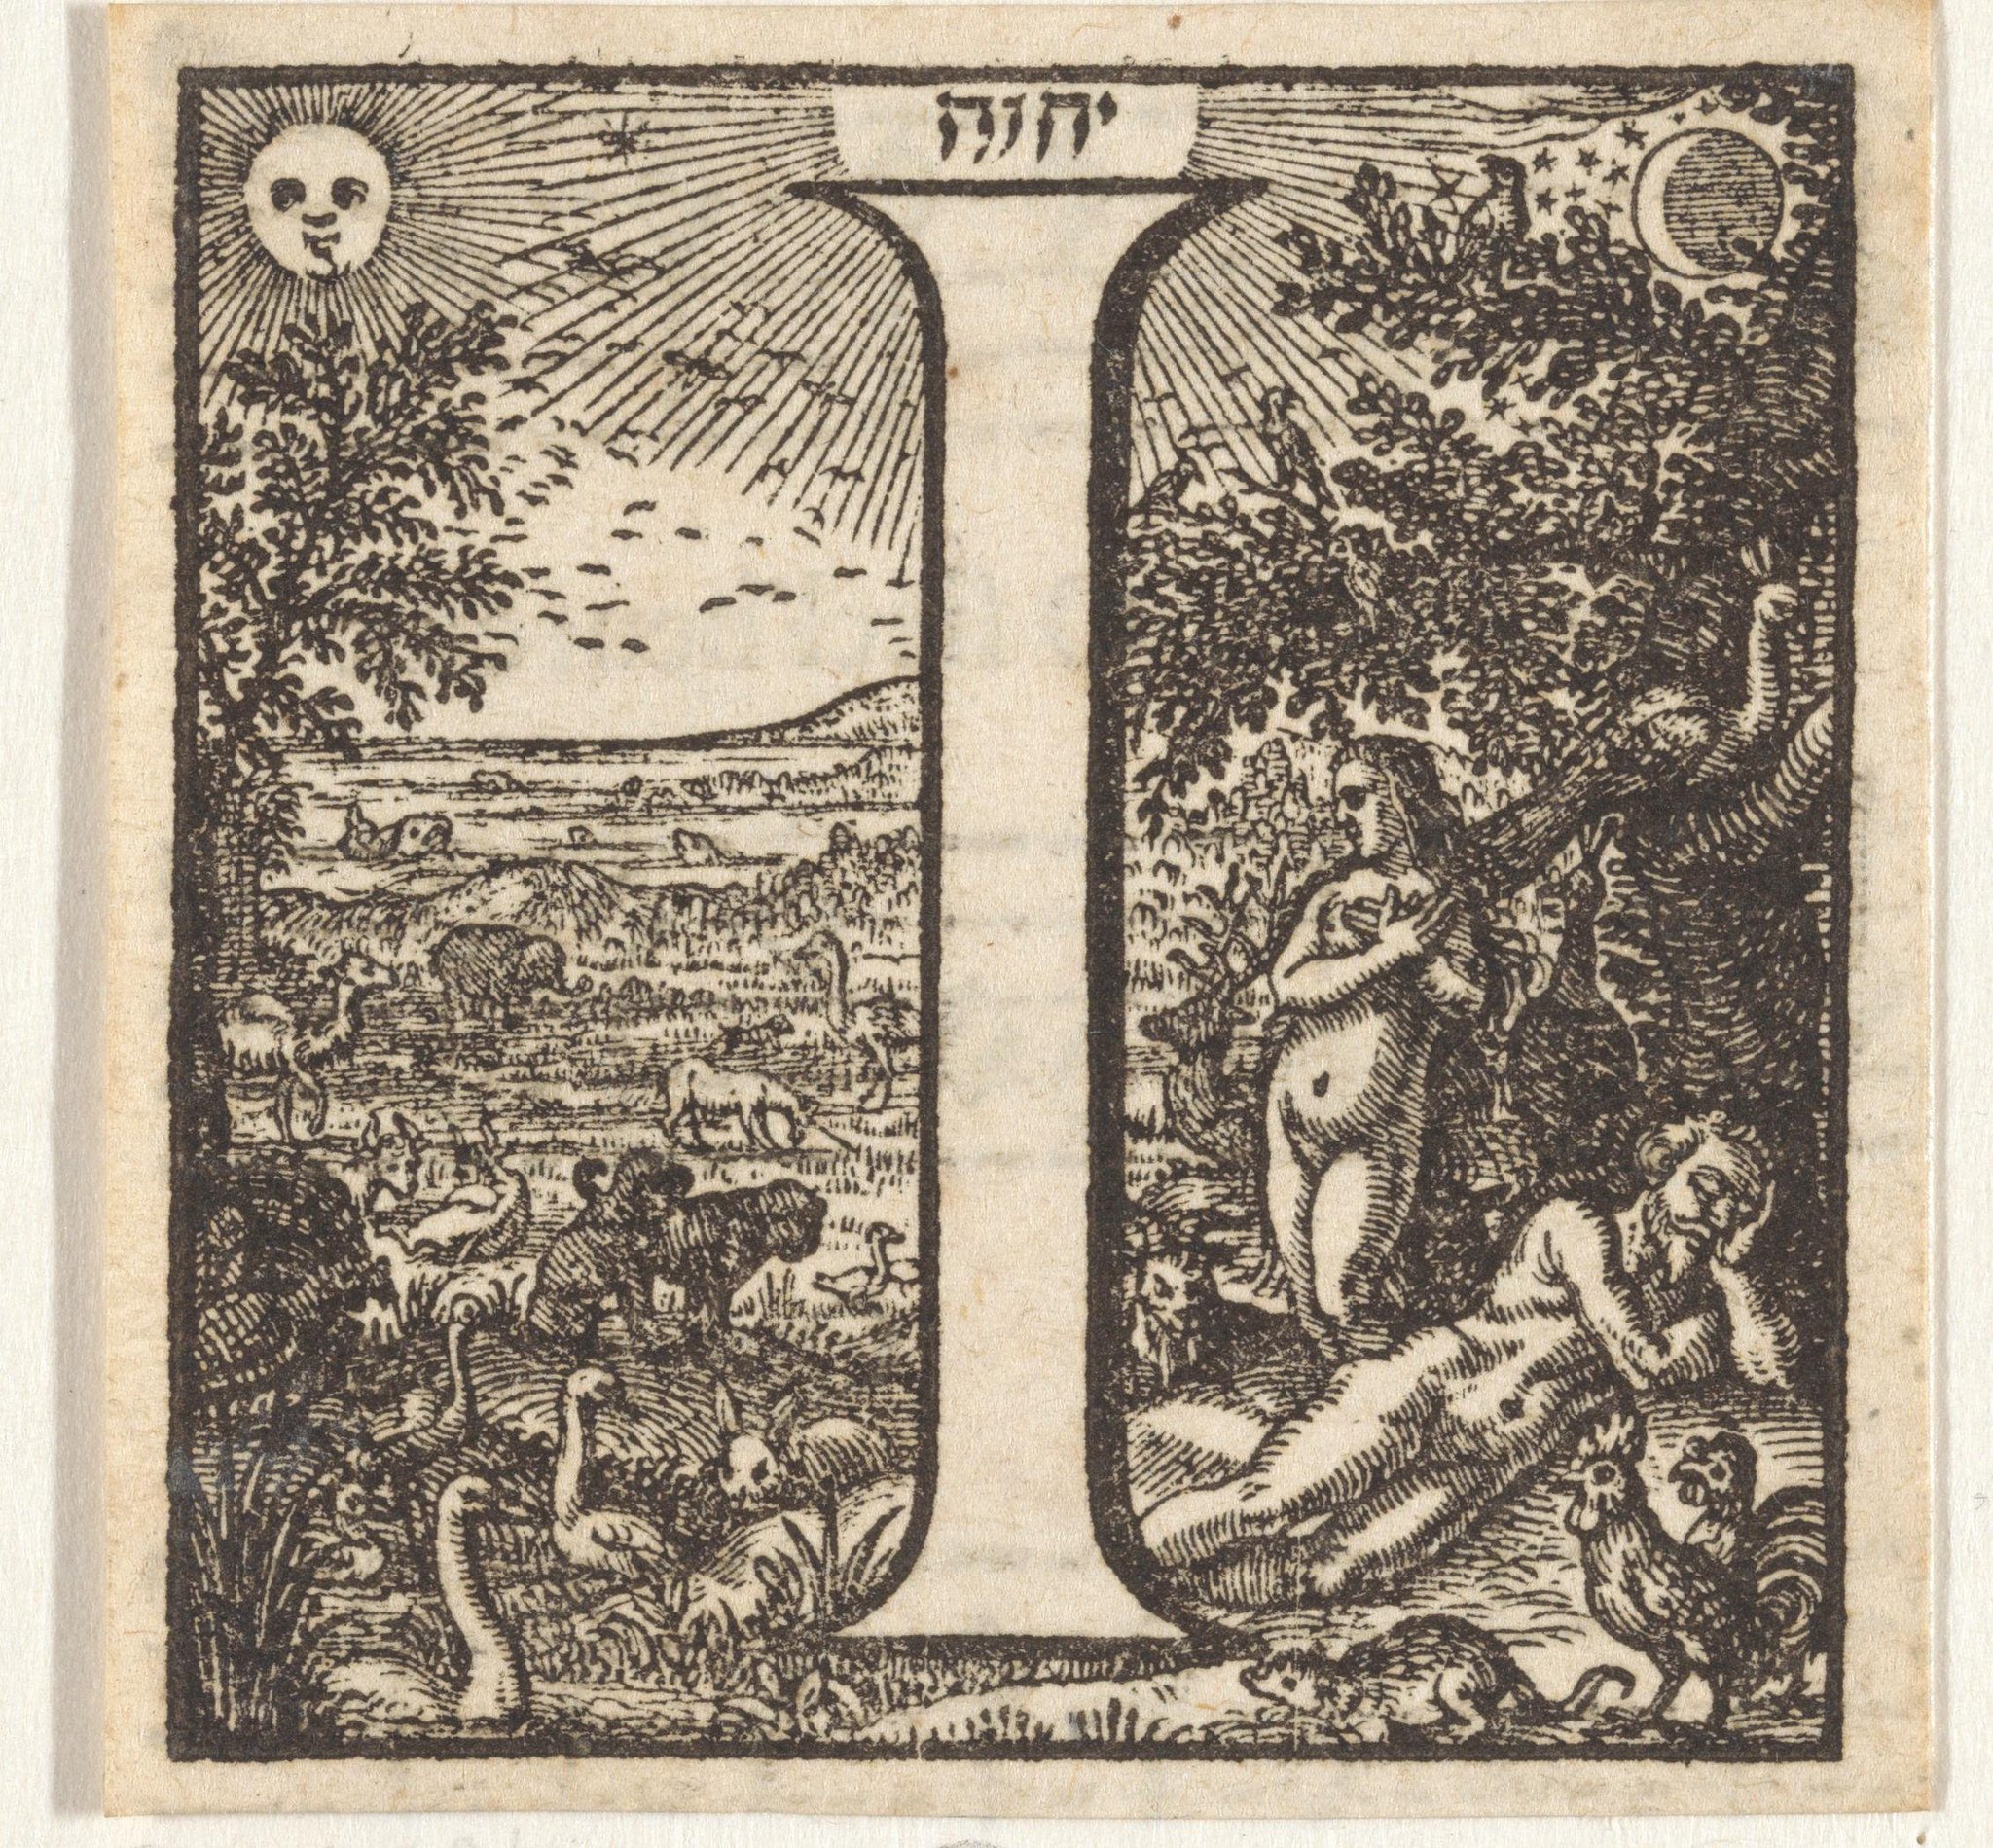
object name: book illustration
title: Letter I in een omlijsting met een voorstelling van Adam en Eva omringd door dieren in het paradijs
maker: Anonymous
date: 1600-1699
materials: paper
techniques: letterpress printing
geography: netherlands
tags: adam and eve in paradise (before the fall), fancy letters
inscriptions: collector's mark: Lugt 240